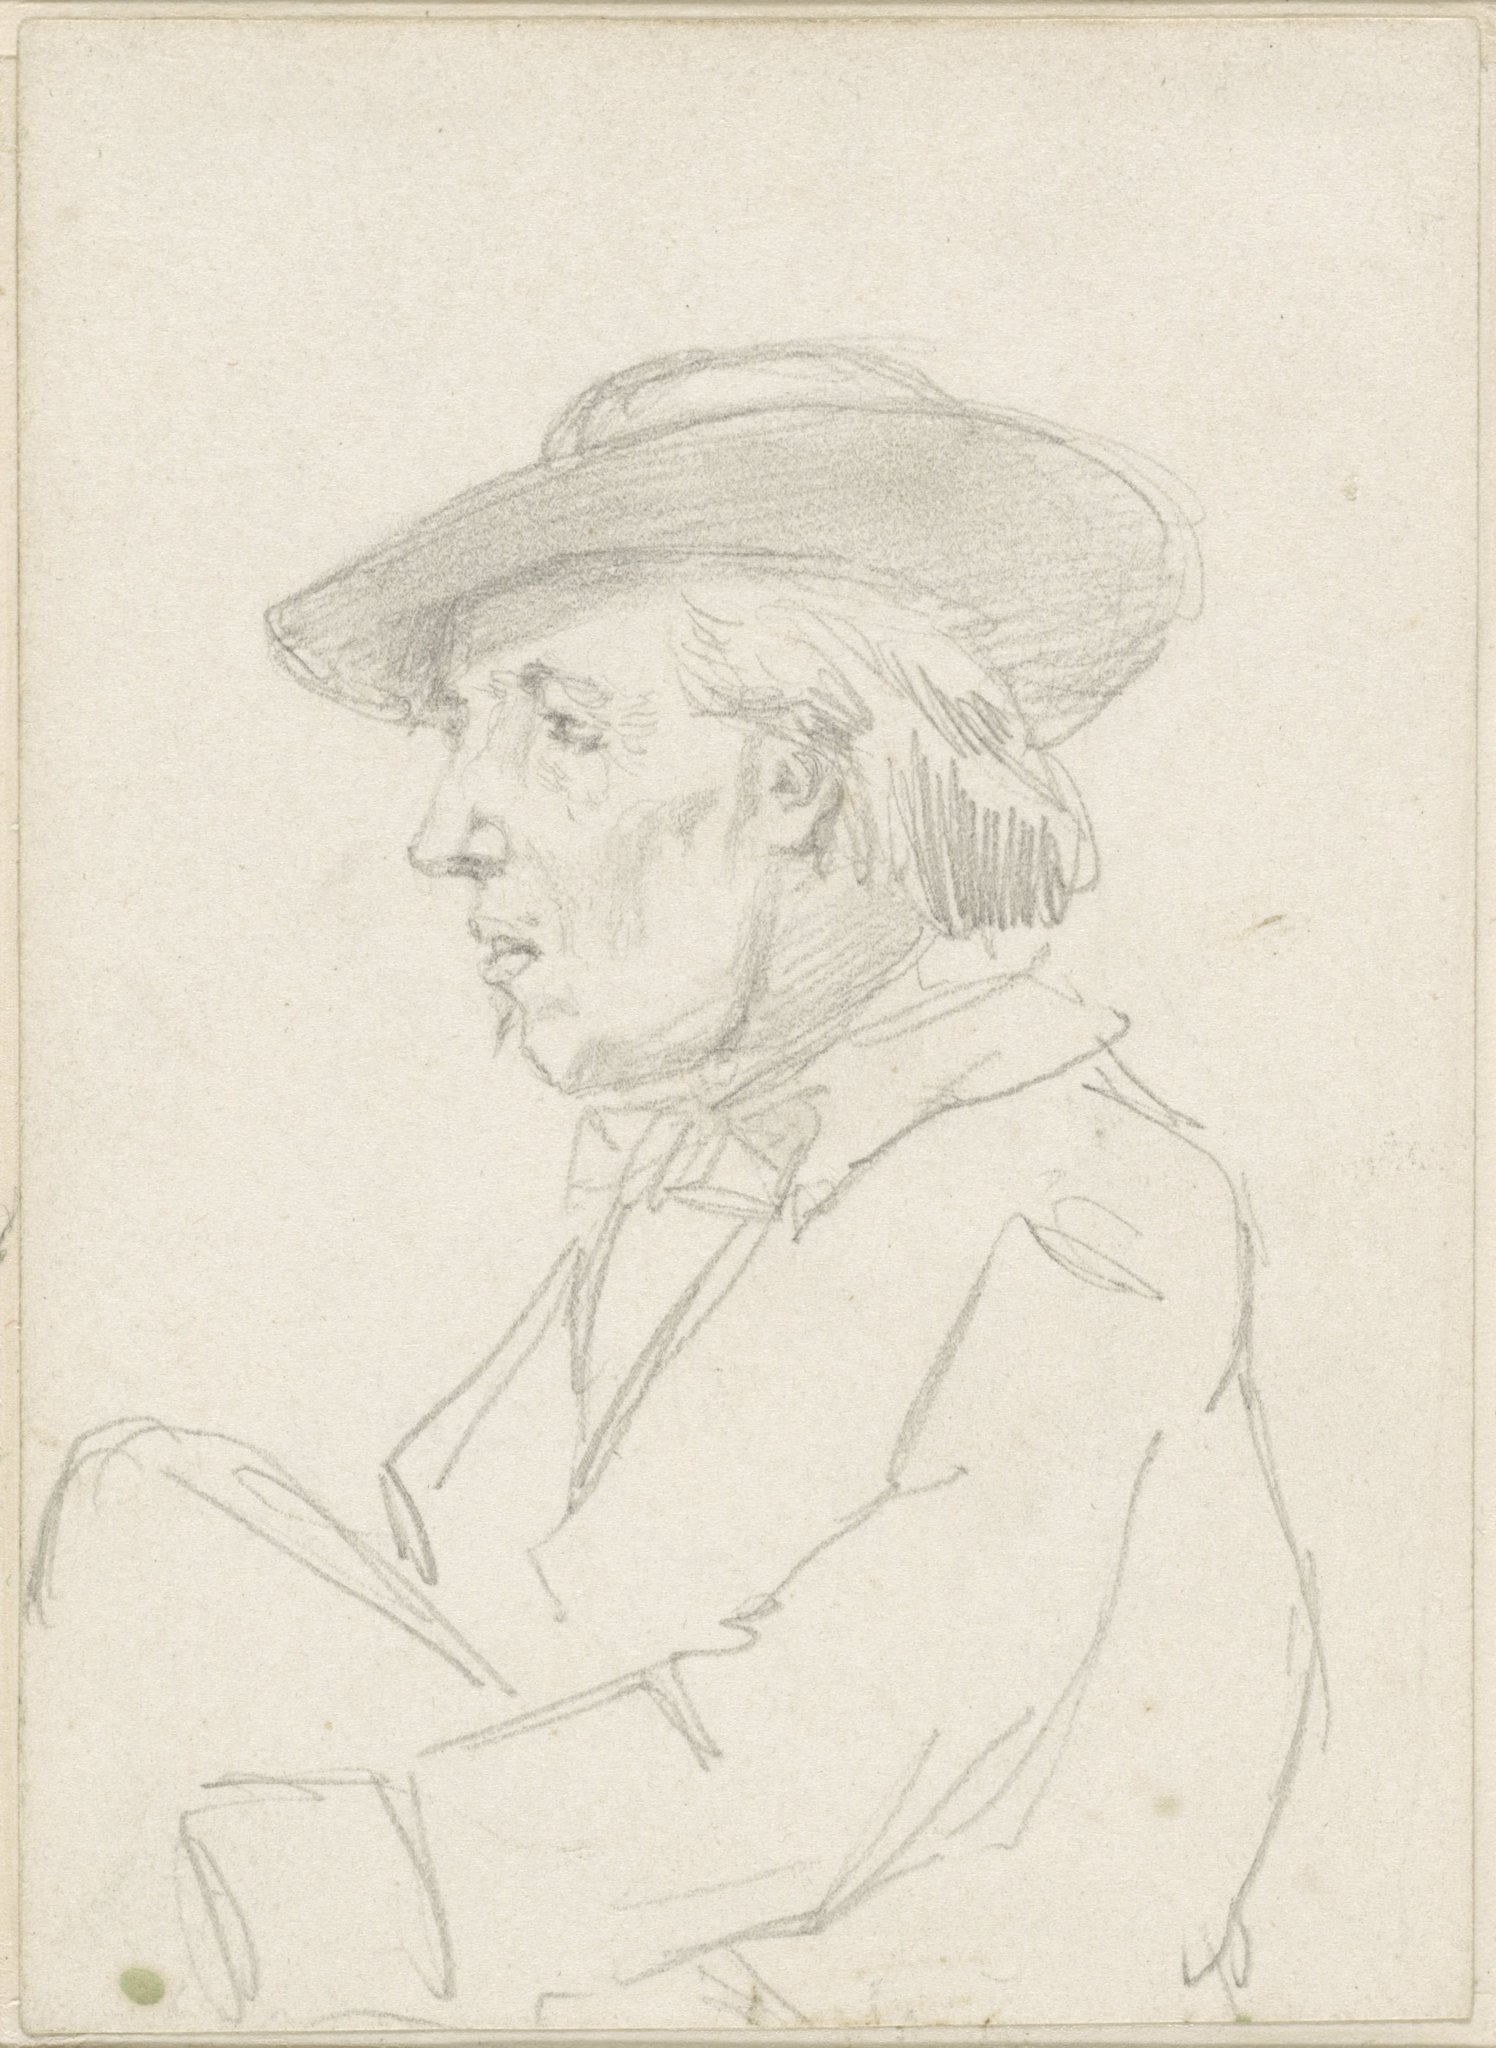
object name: drawing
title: Portret van Hendricus Johannes Scheeres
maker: jan weissenbruch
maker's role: painter, print maker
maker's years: 1822-1880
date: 1832-1880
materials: paper, pencil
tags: the hague, print maker, hendricus johannes scheeres, historical persons, portrait, self-portrait of artist